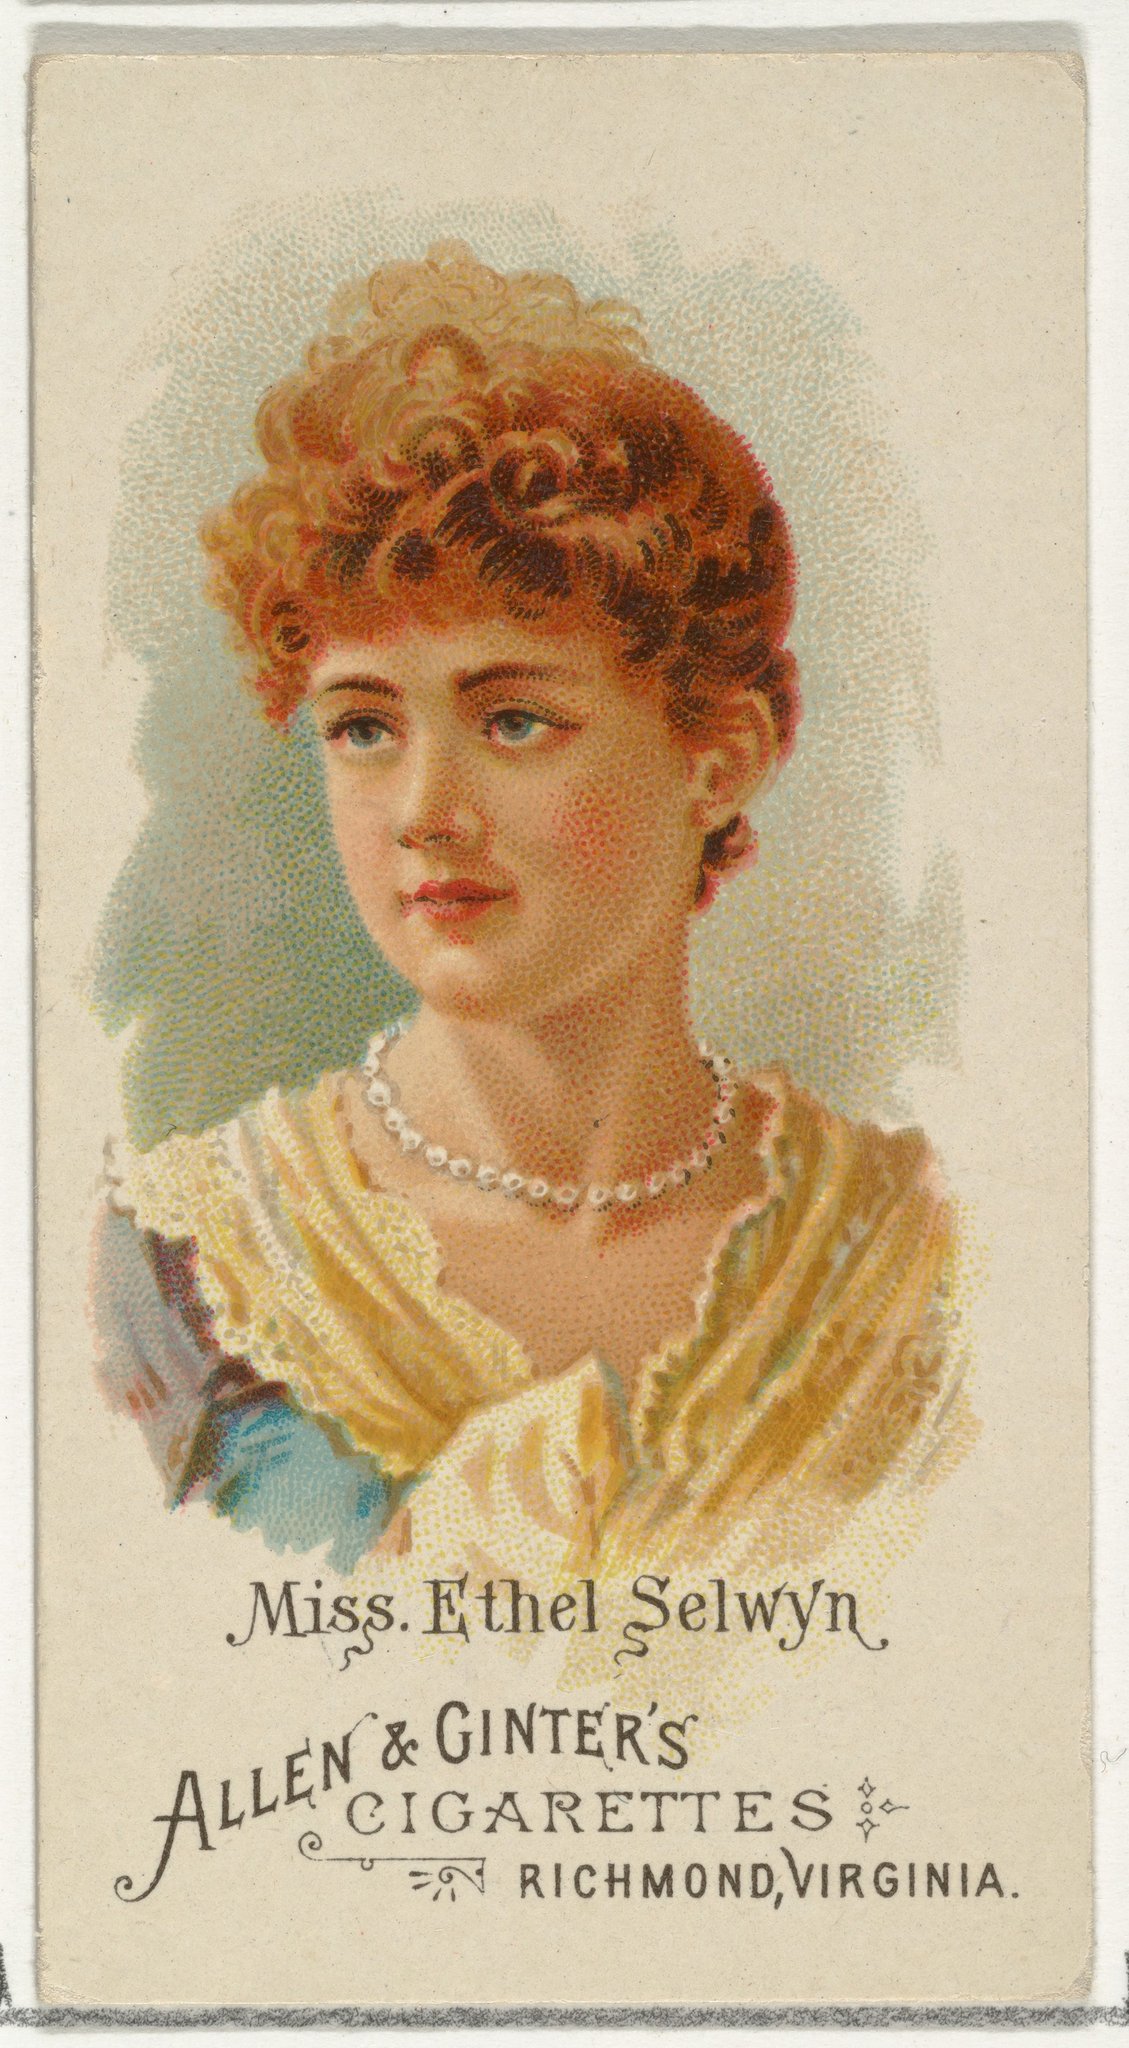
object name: print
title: Miss Ethel Selwyn, from World's Beauties, Series 1 (N26) for Allen & Ginter Cigarettes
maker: allen & ginter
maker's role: publisher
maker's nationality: american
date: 1888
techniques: color lithograph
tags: women